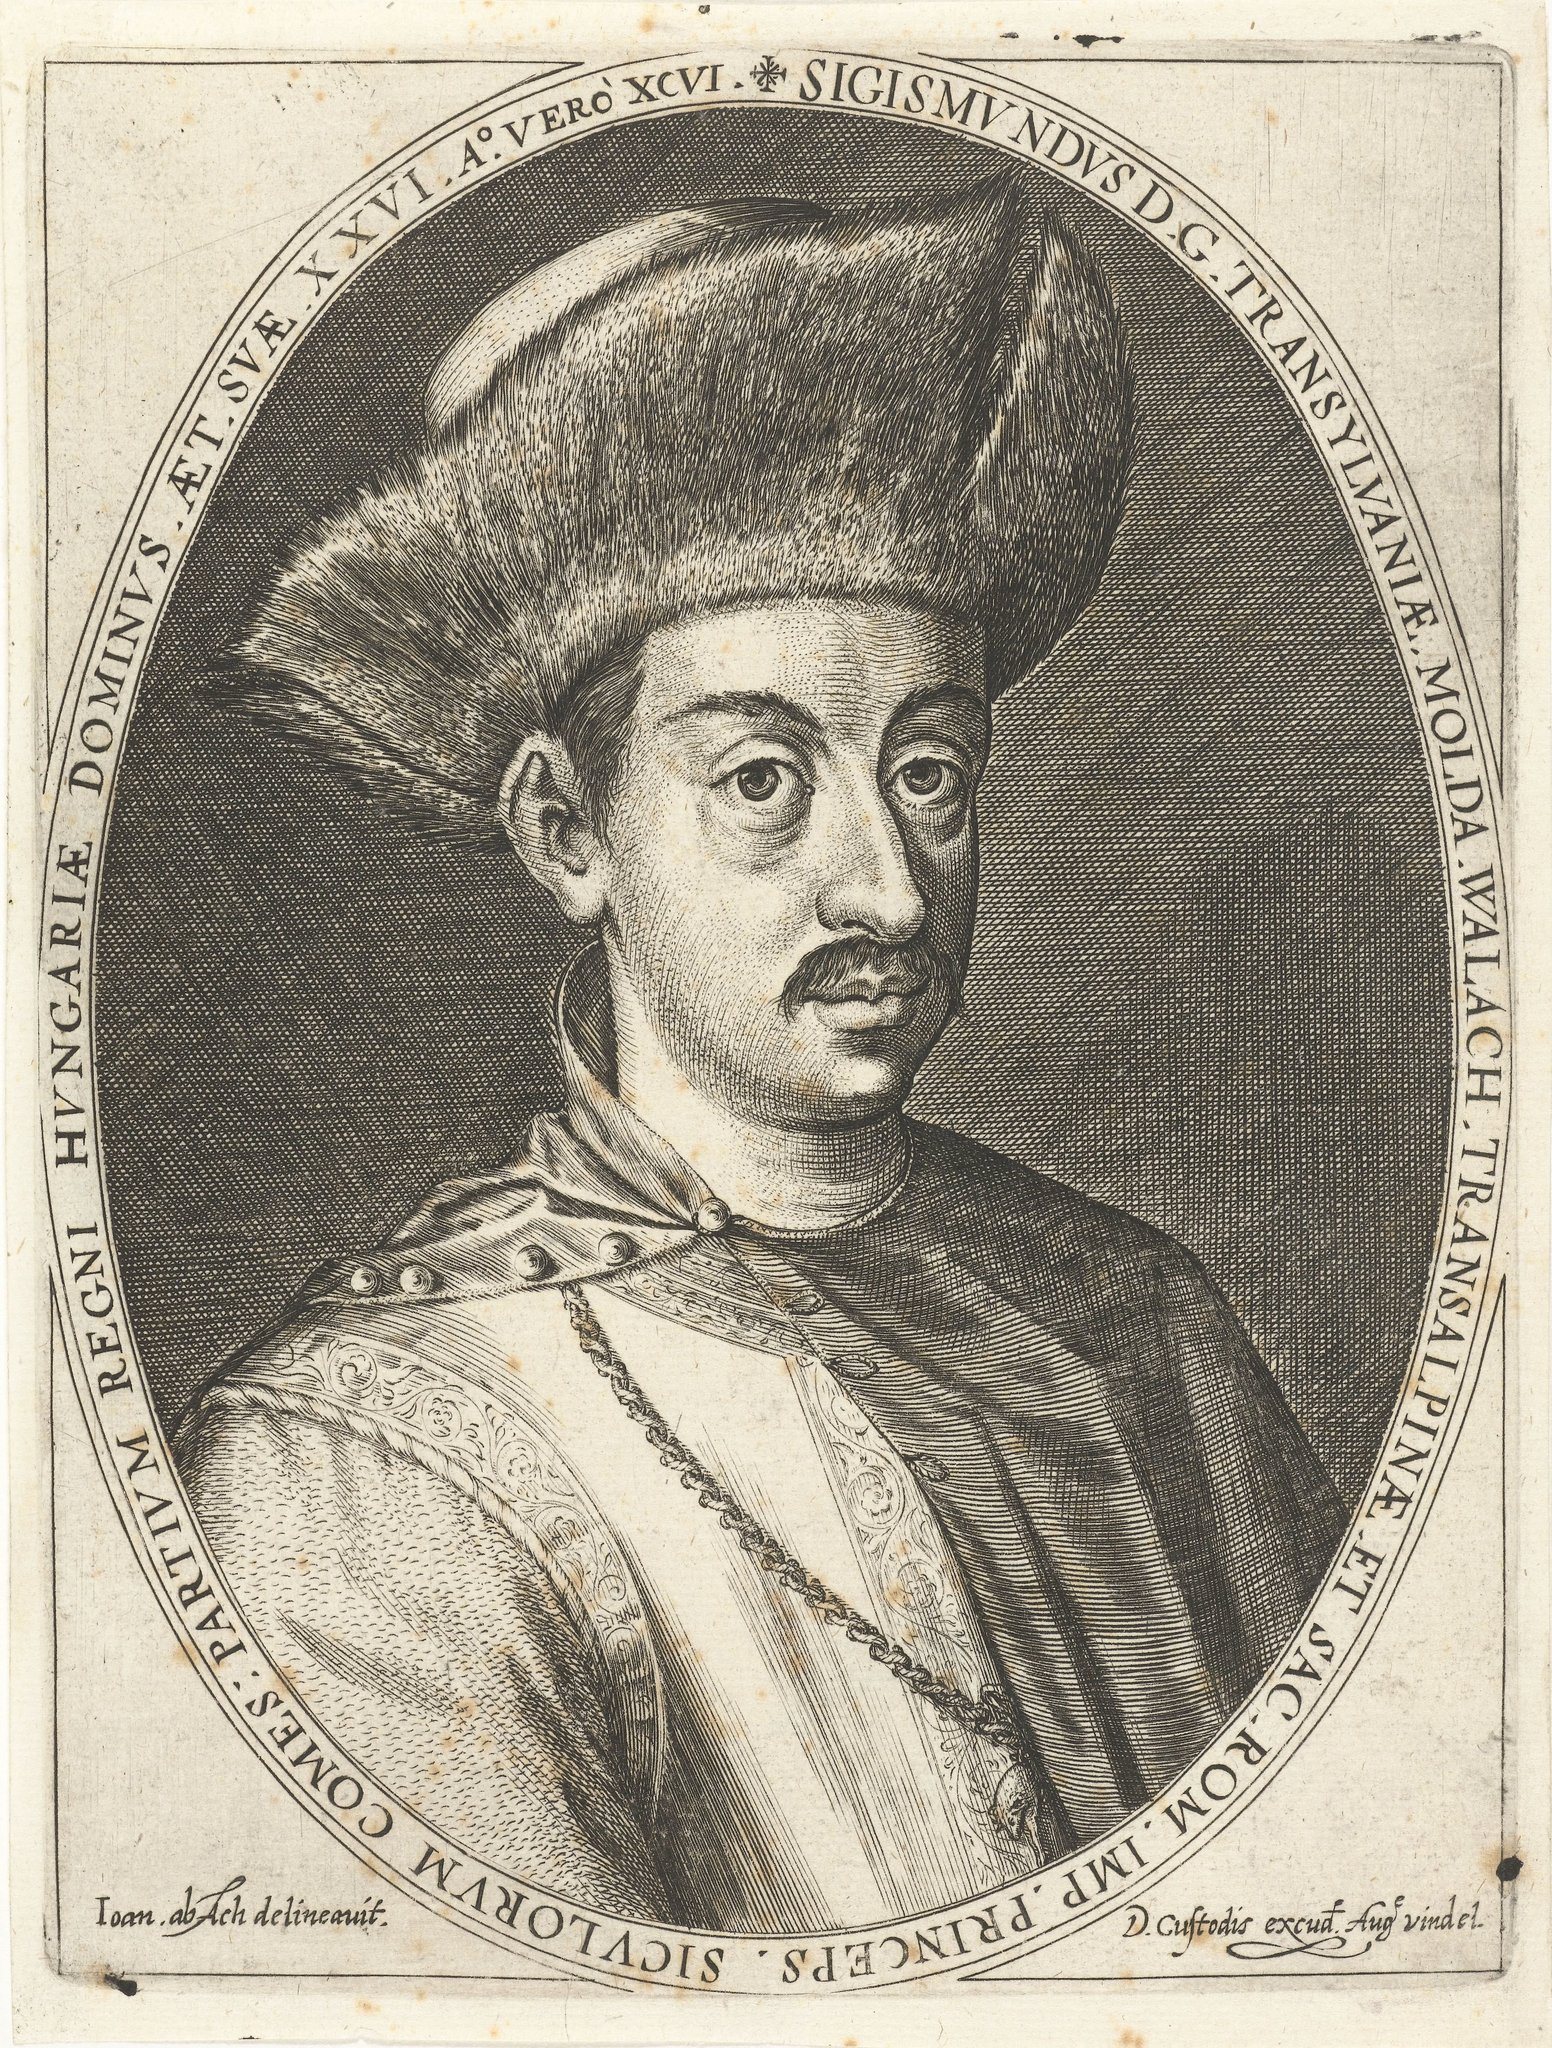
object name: print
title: Portret van Sigismund Báthory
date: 1600-1604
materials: paper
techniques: engraving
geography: augsburg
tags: sigismund báthory (prins van transylvanië)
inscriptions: collector's mark: Lugt 240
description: Illustratie uit: D. Custos en M. Henning. Atrium heroicum Caesarum, regum aliorq. summatum ac procerum qui intra proximum seculum vixere, aut hodie supersunt, imaginib. Deel 1-4. Augsburg: D. Custos, 1600-1604.